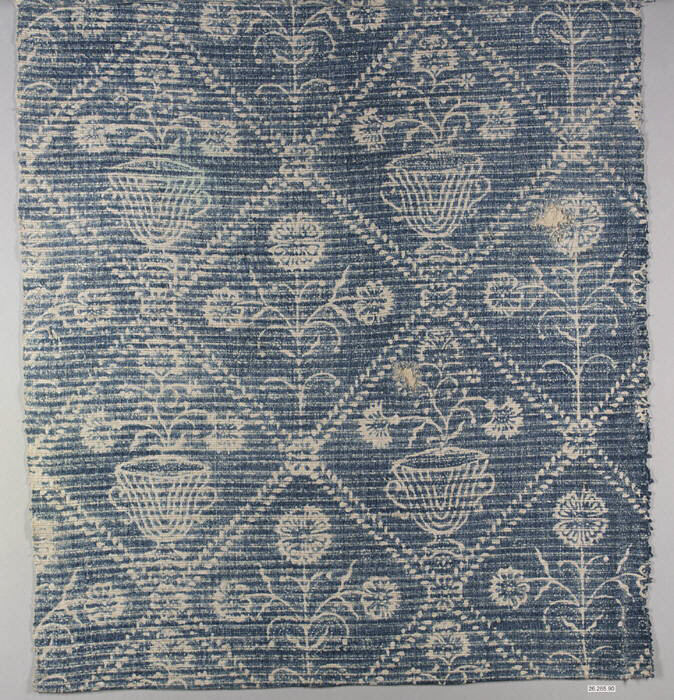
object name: fragment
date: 1767-1800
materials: linen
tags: flowers